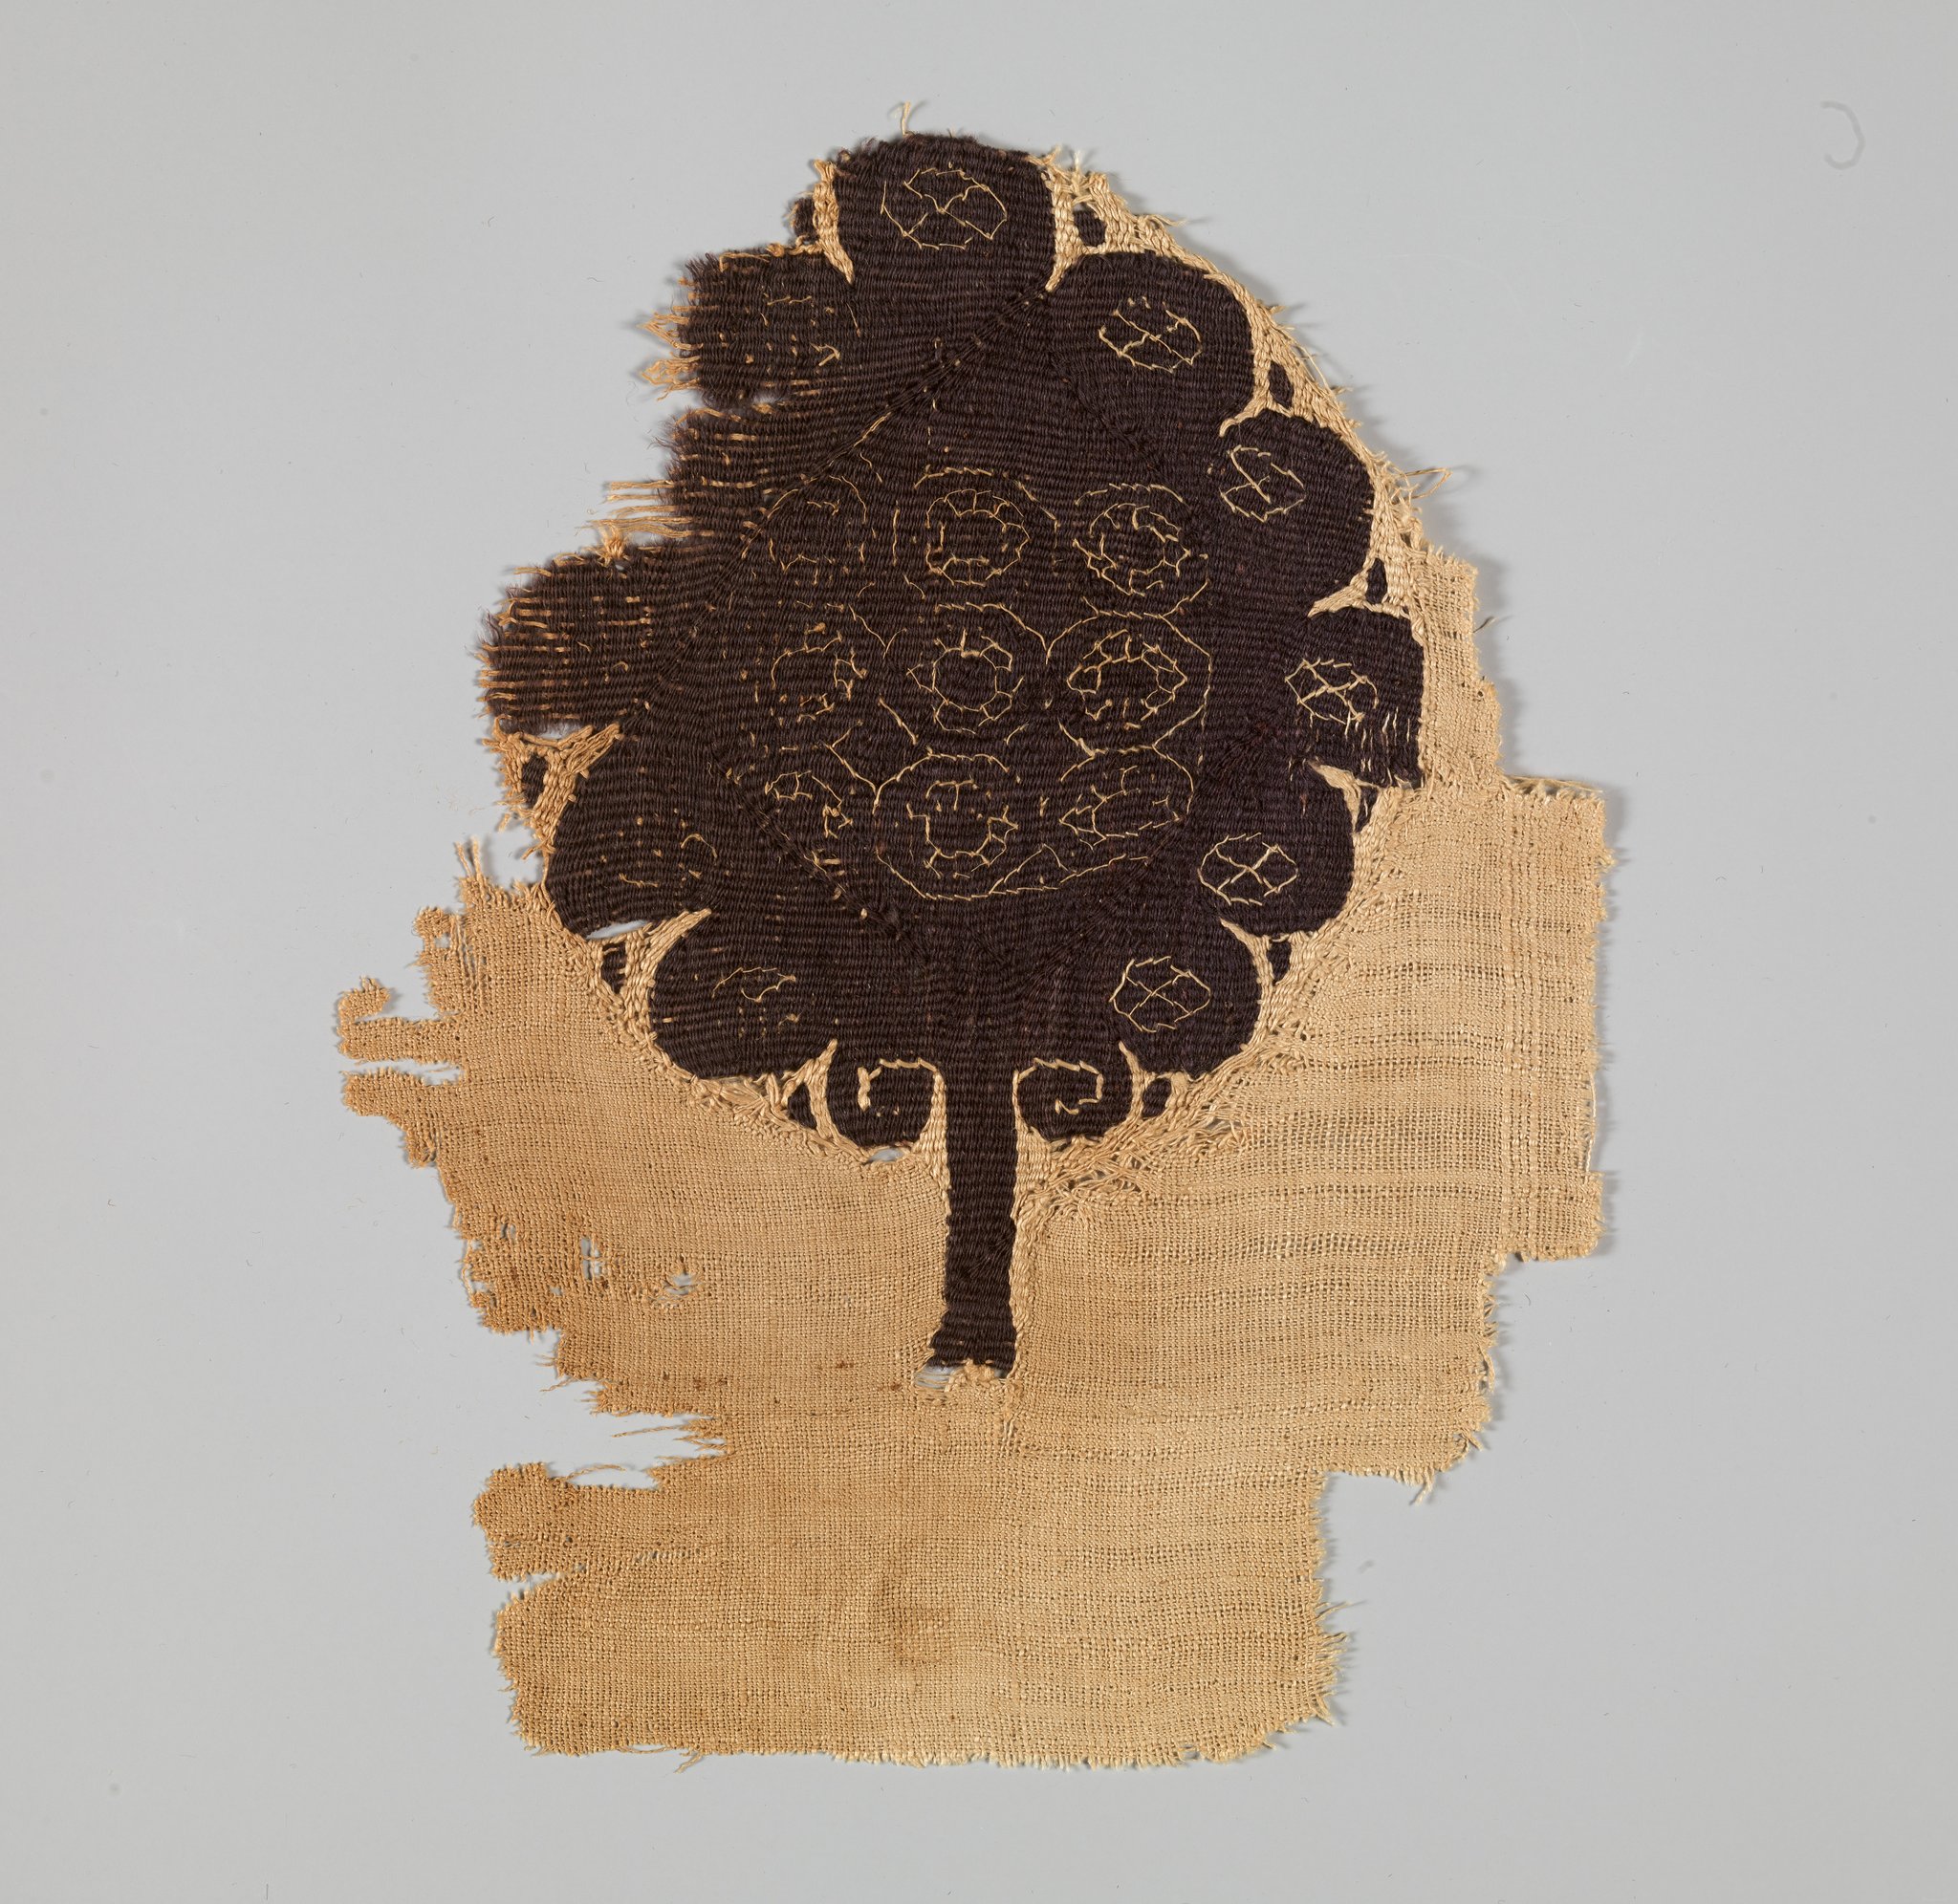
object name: textile fragment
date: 301-400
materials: linen, wool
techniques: weave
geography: egypt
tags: leaves